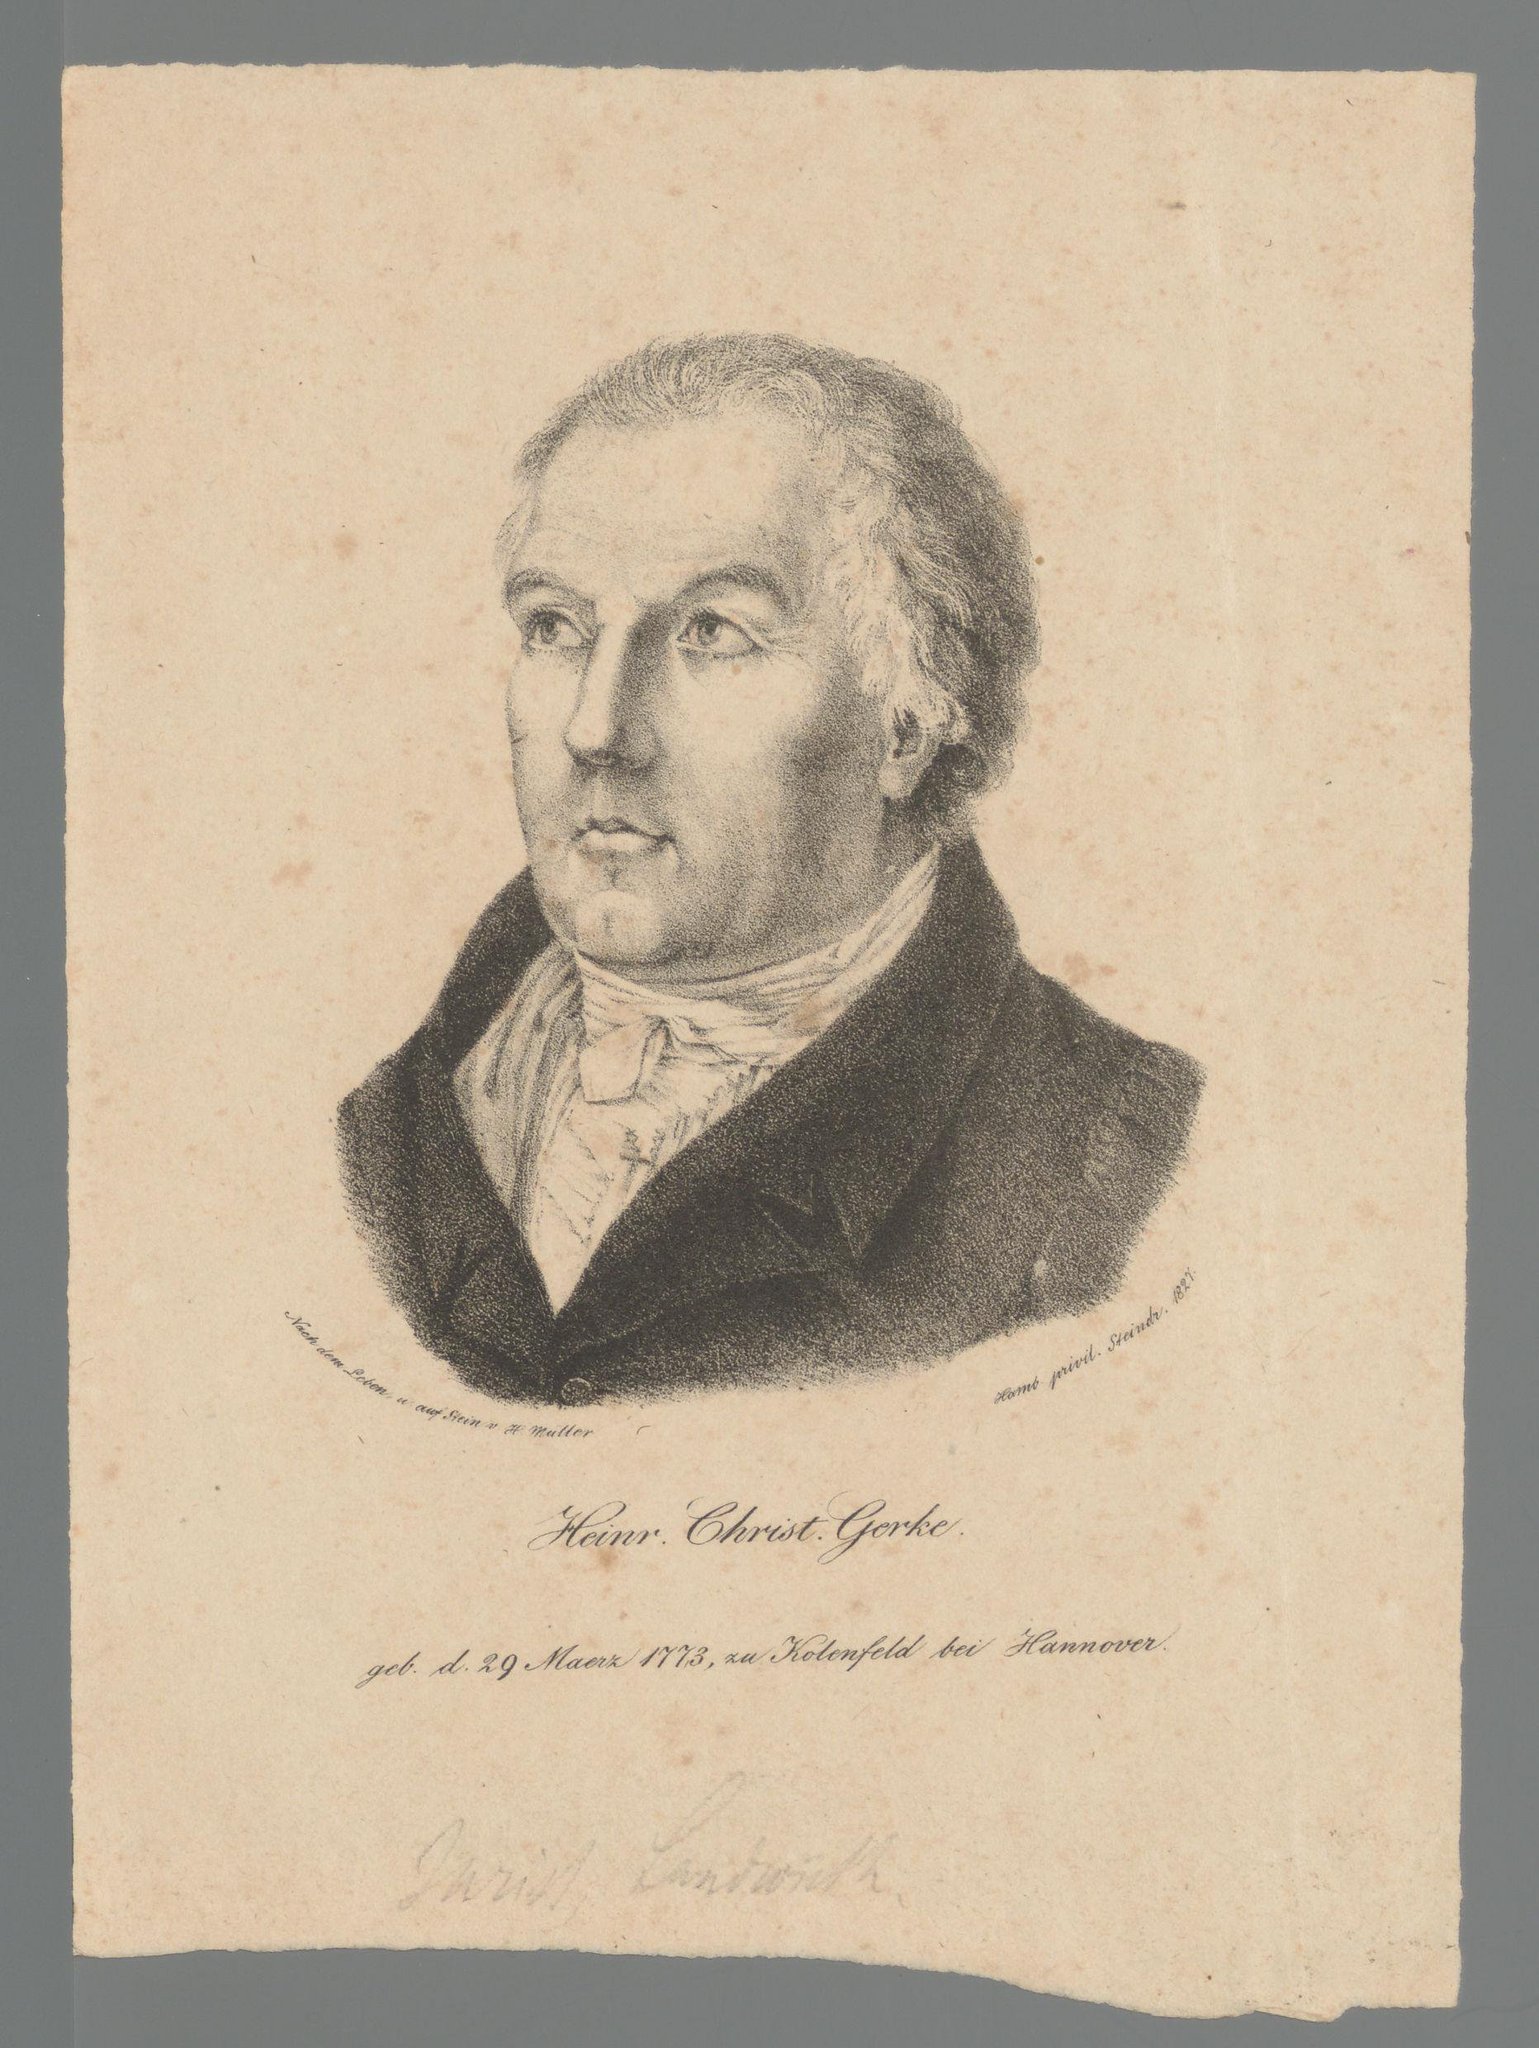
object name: print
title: Heinr. Christ. Gerke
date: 1827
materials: paper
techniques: lithograph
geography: hamburg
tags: adult man, historical persons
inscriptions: collector's mark: Lugt 2228